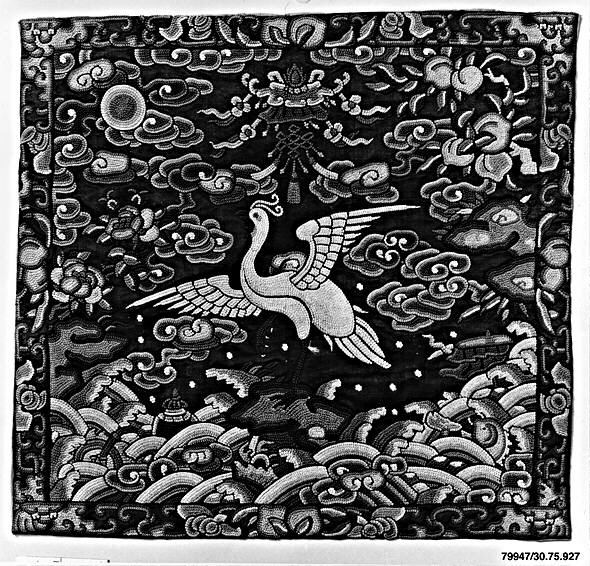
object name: rank badge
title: Rank Badge with Egret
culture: chinese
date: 1767-1833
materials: silk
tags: birds